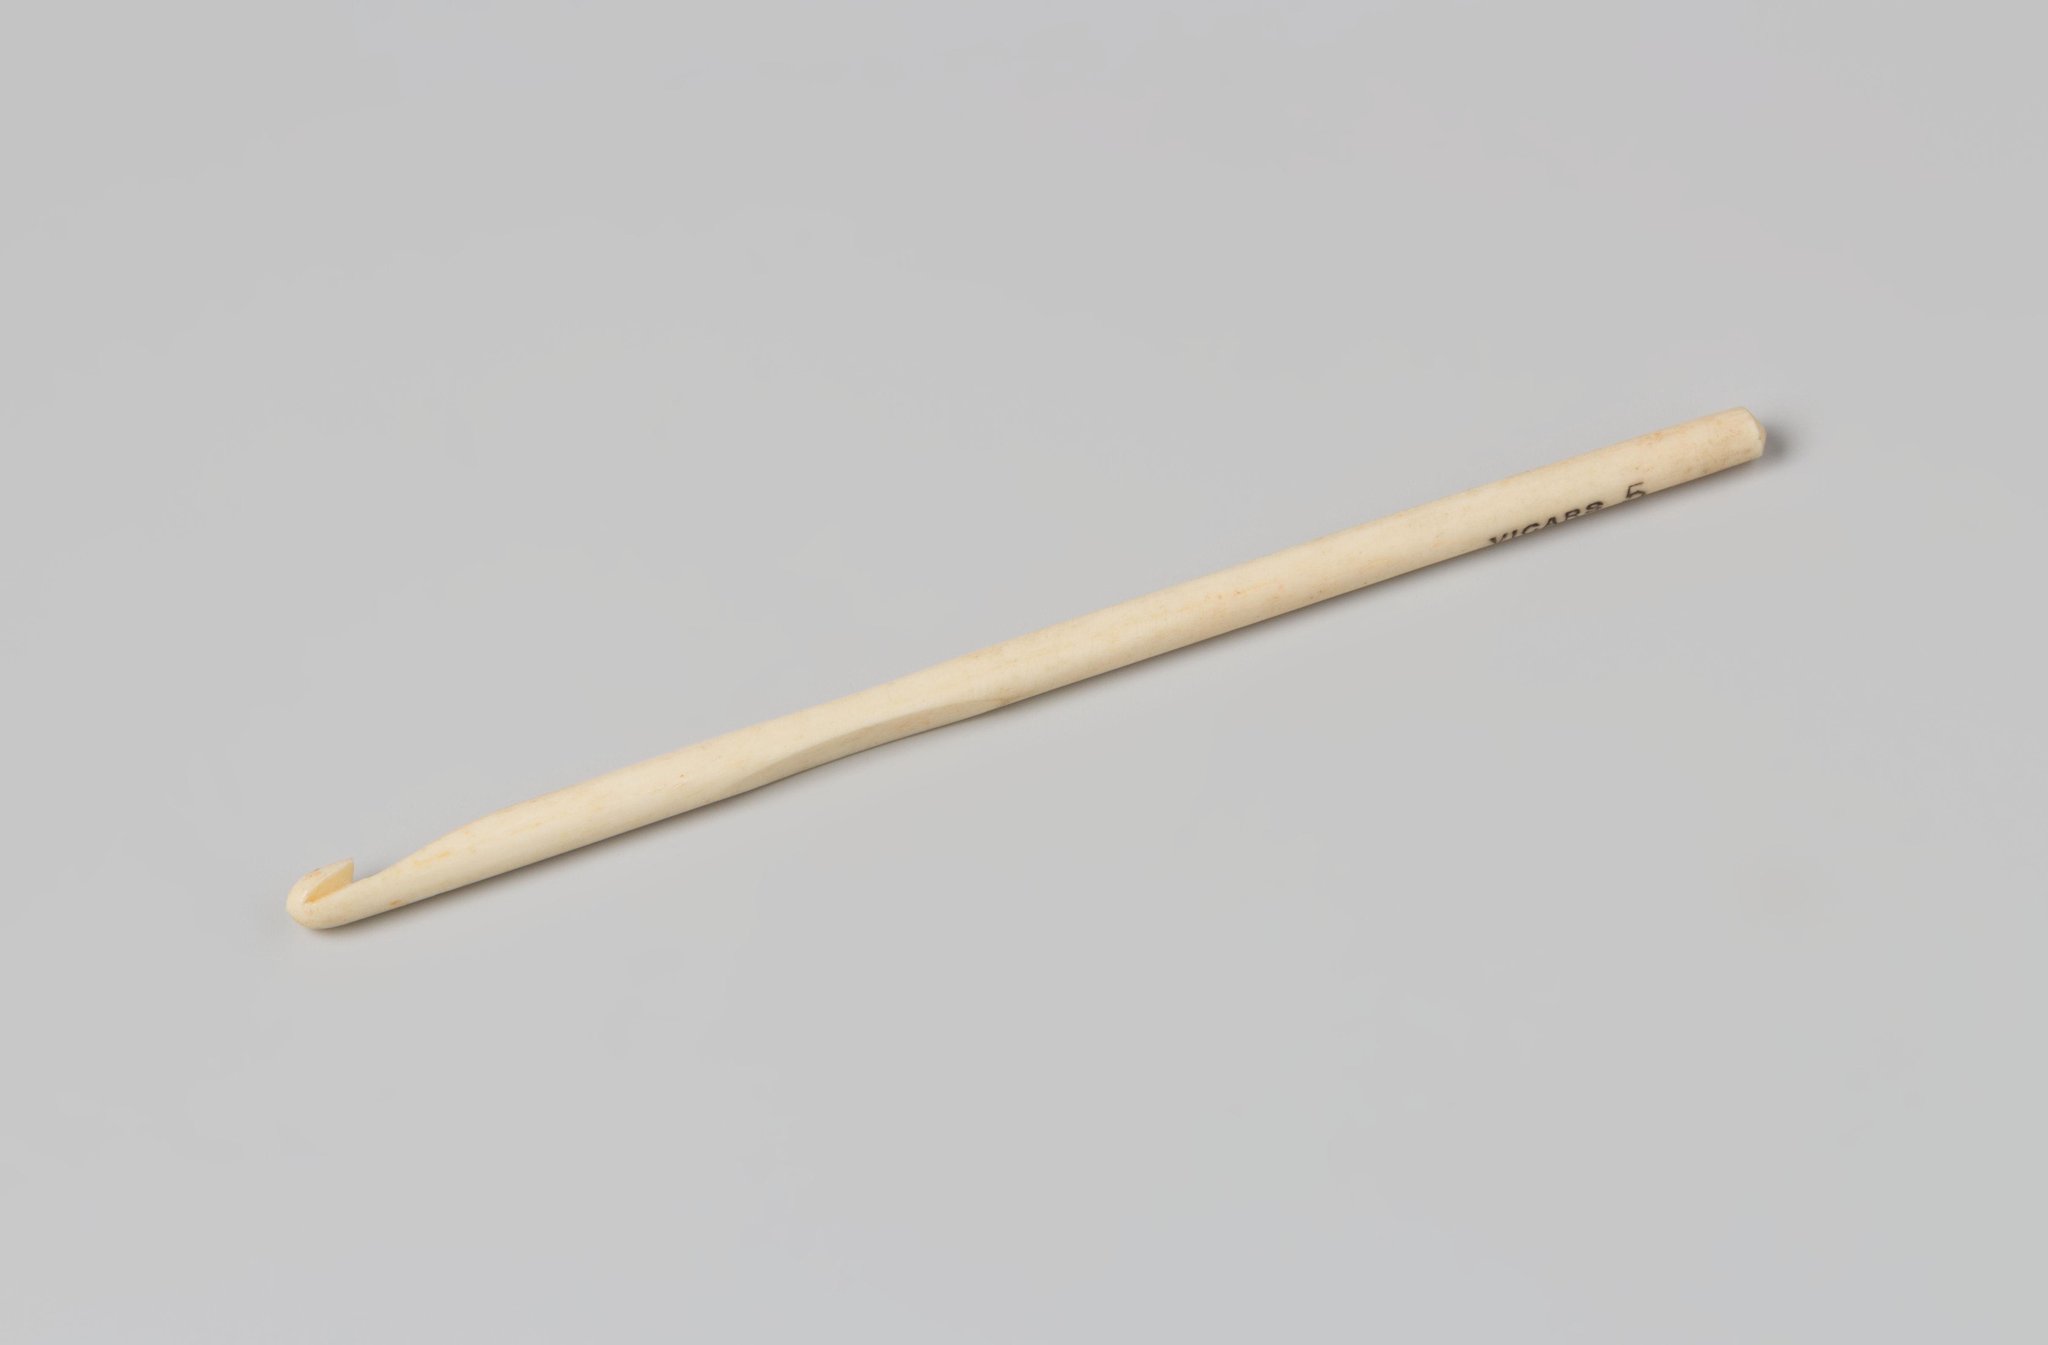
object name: haaknaald, haakpen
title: Haakpen van kunststof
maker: john vicars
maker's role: schrijver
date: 1900-1950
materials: plastic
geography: england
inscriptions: company name: ‘'Vicars'’